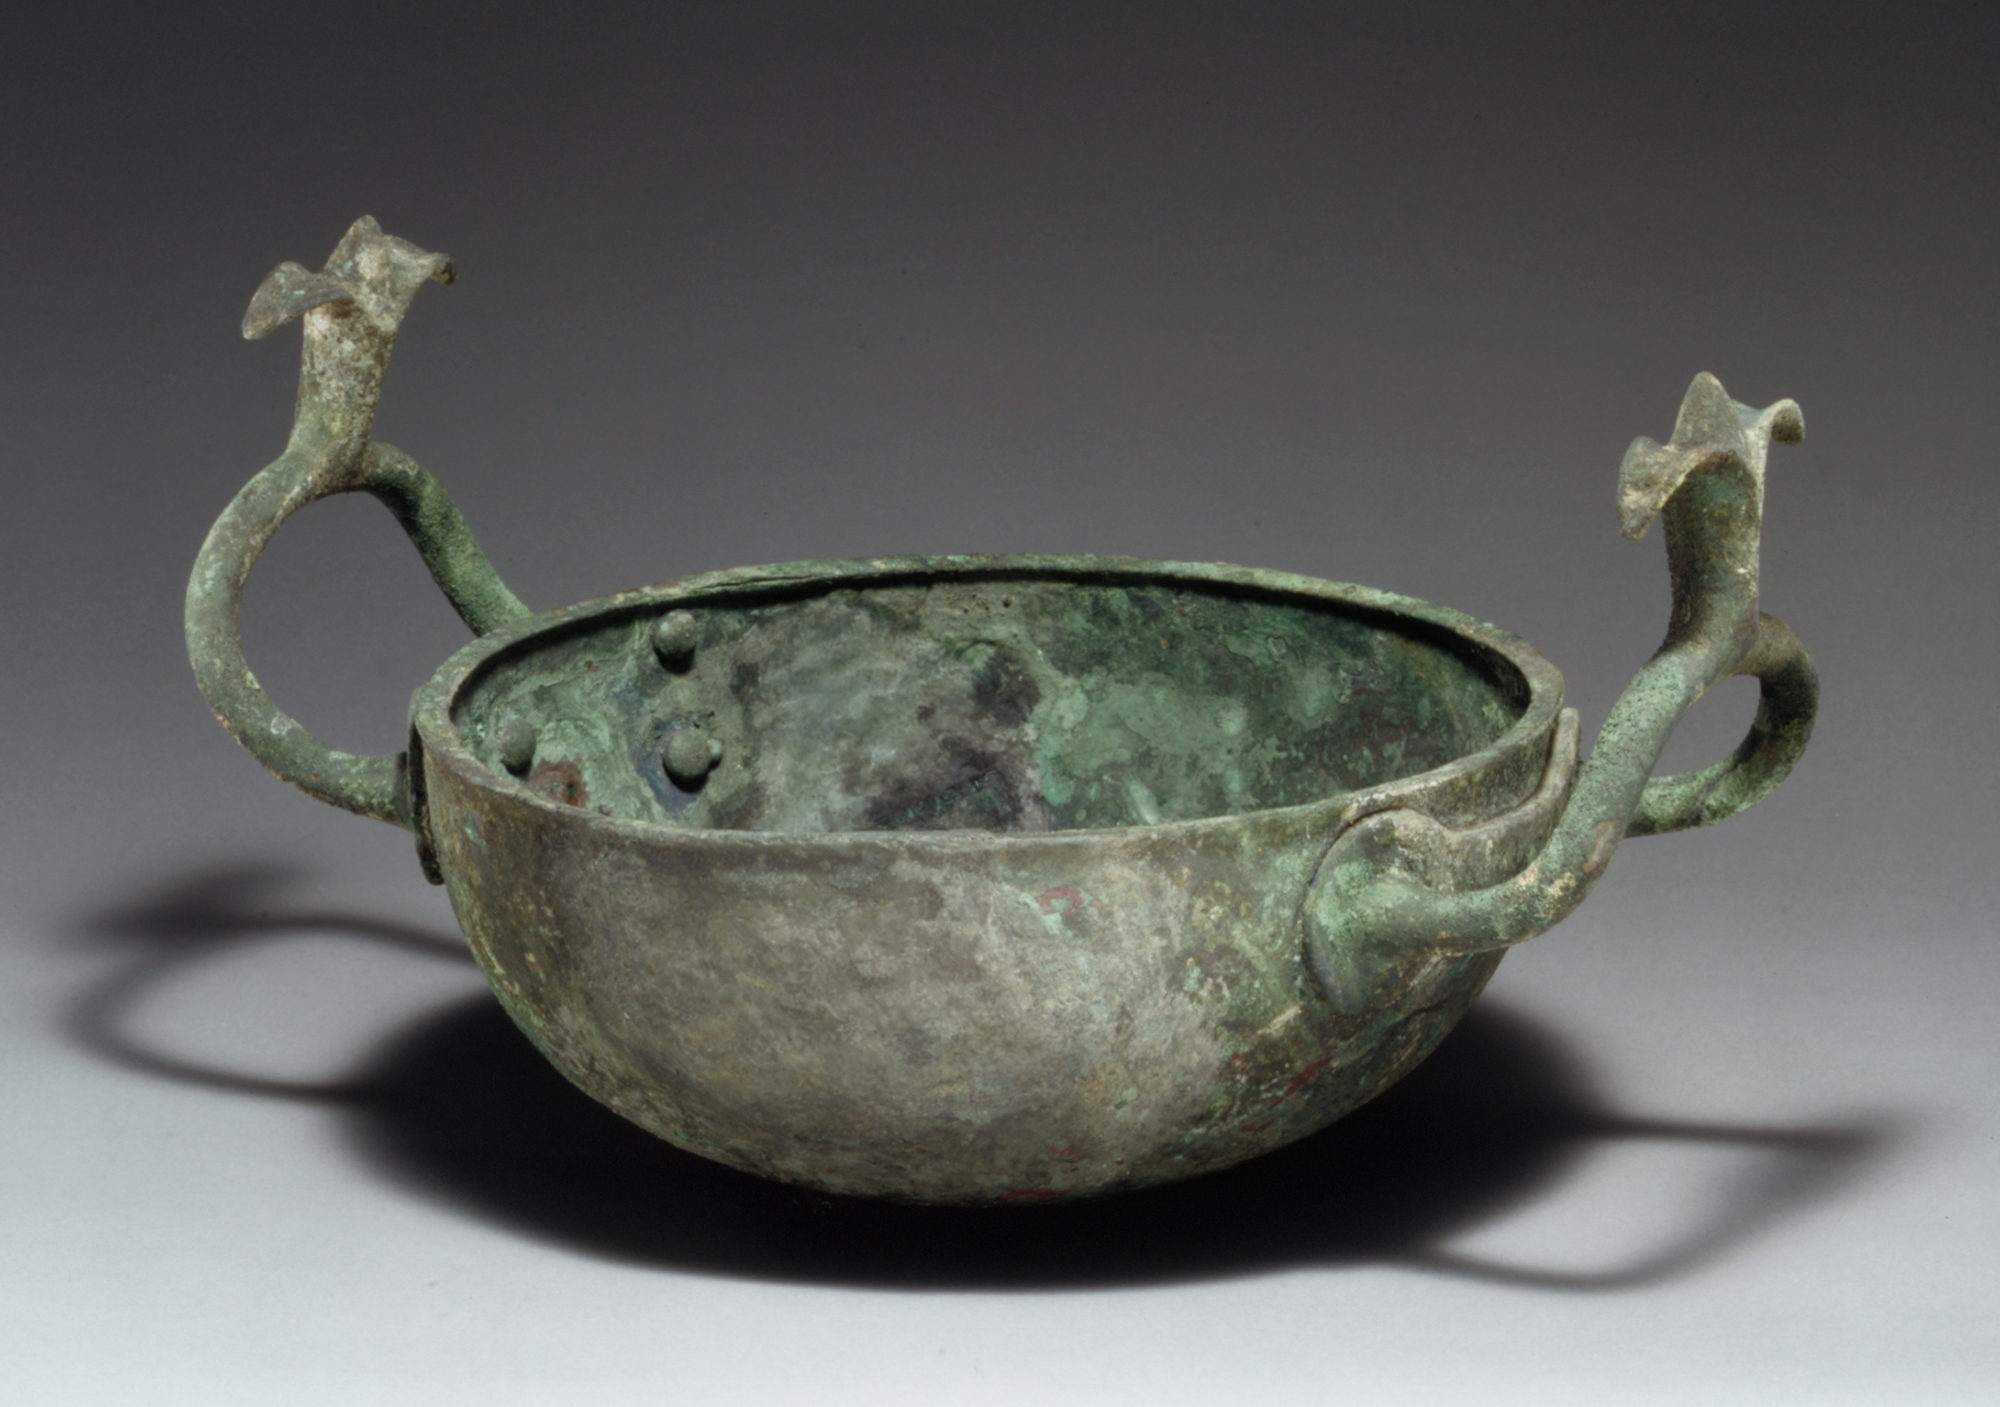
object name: bowl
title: Bronze bowl with handles terminating in lotuses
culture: cypriot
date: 850-750 BCE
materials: bronze